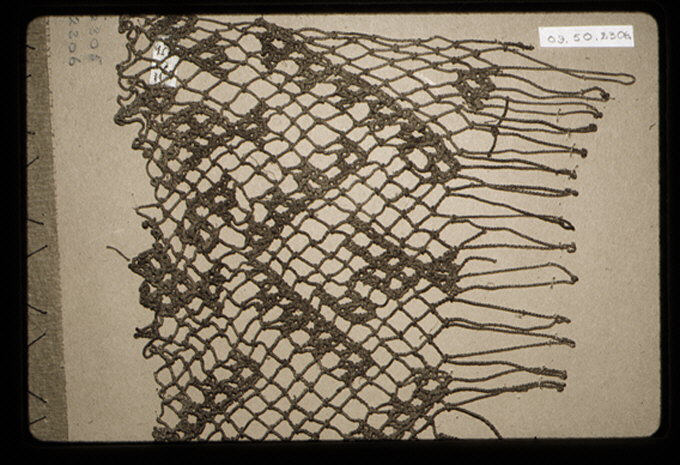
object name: net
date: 401-700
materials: linen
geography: egypt